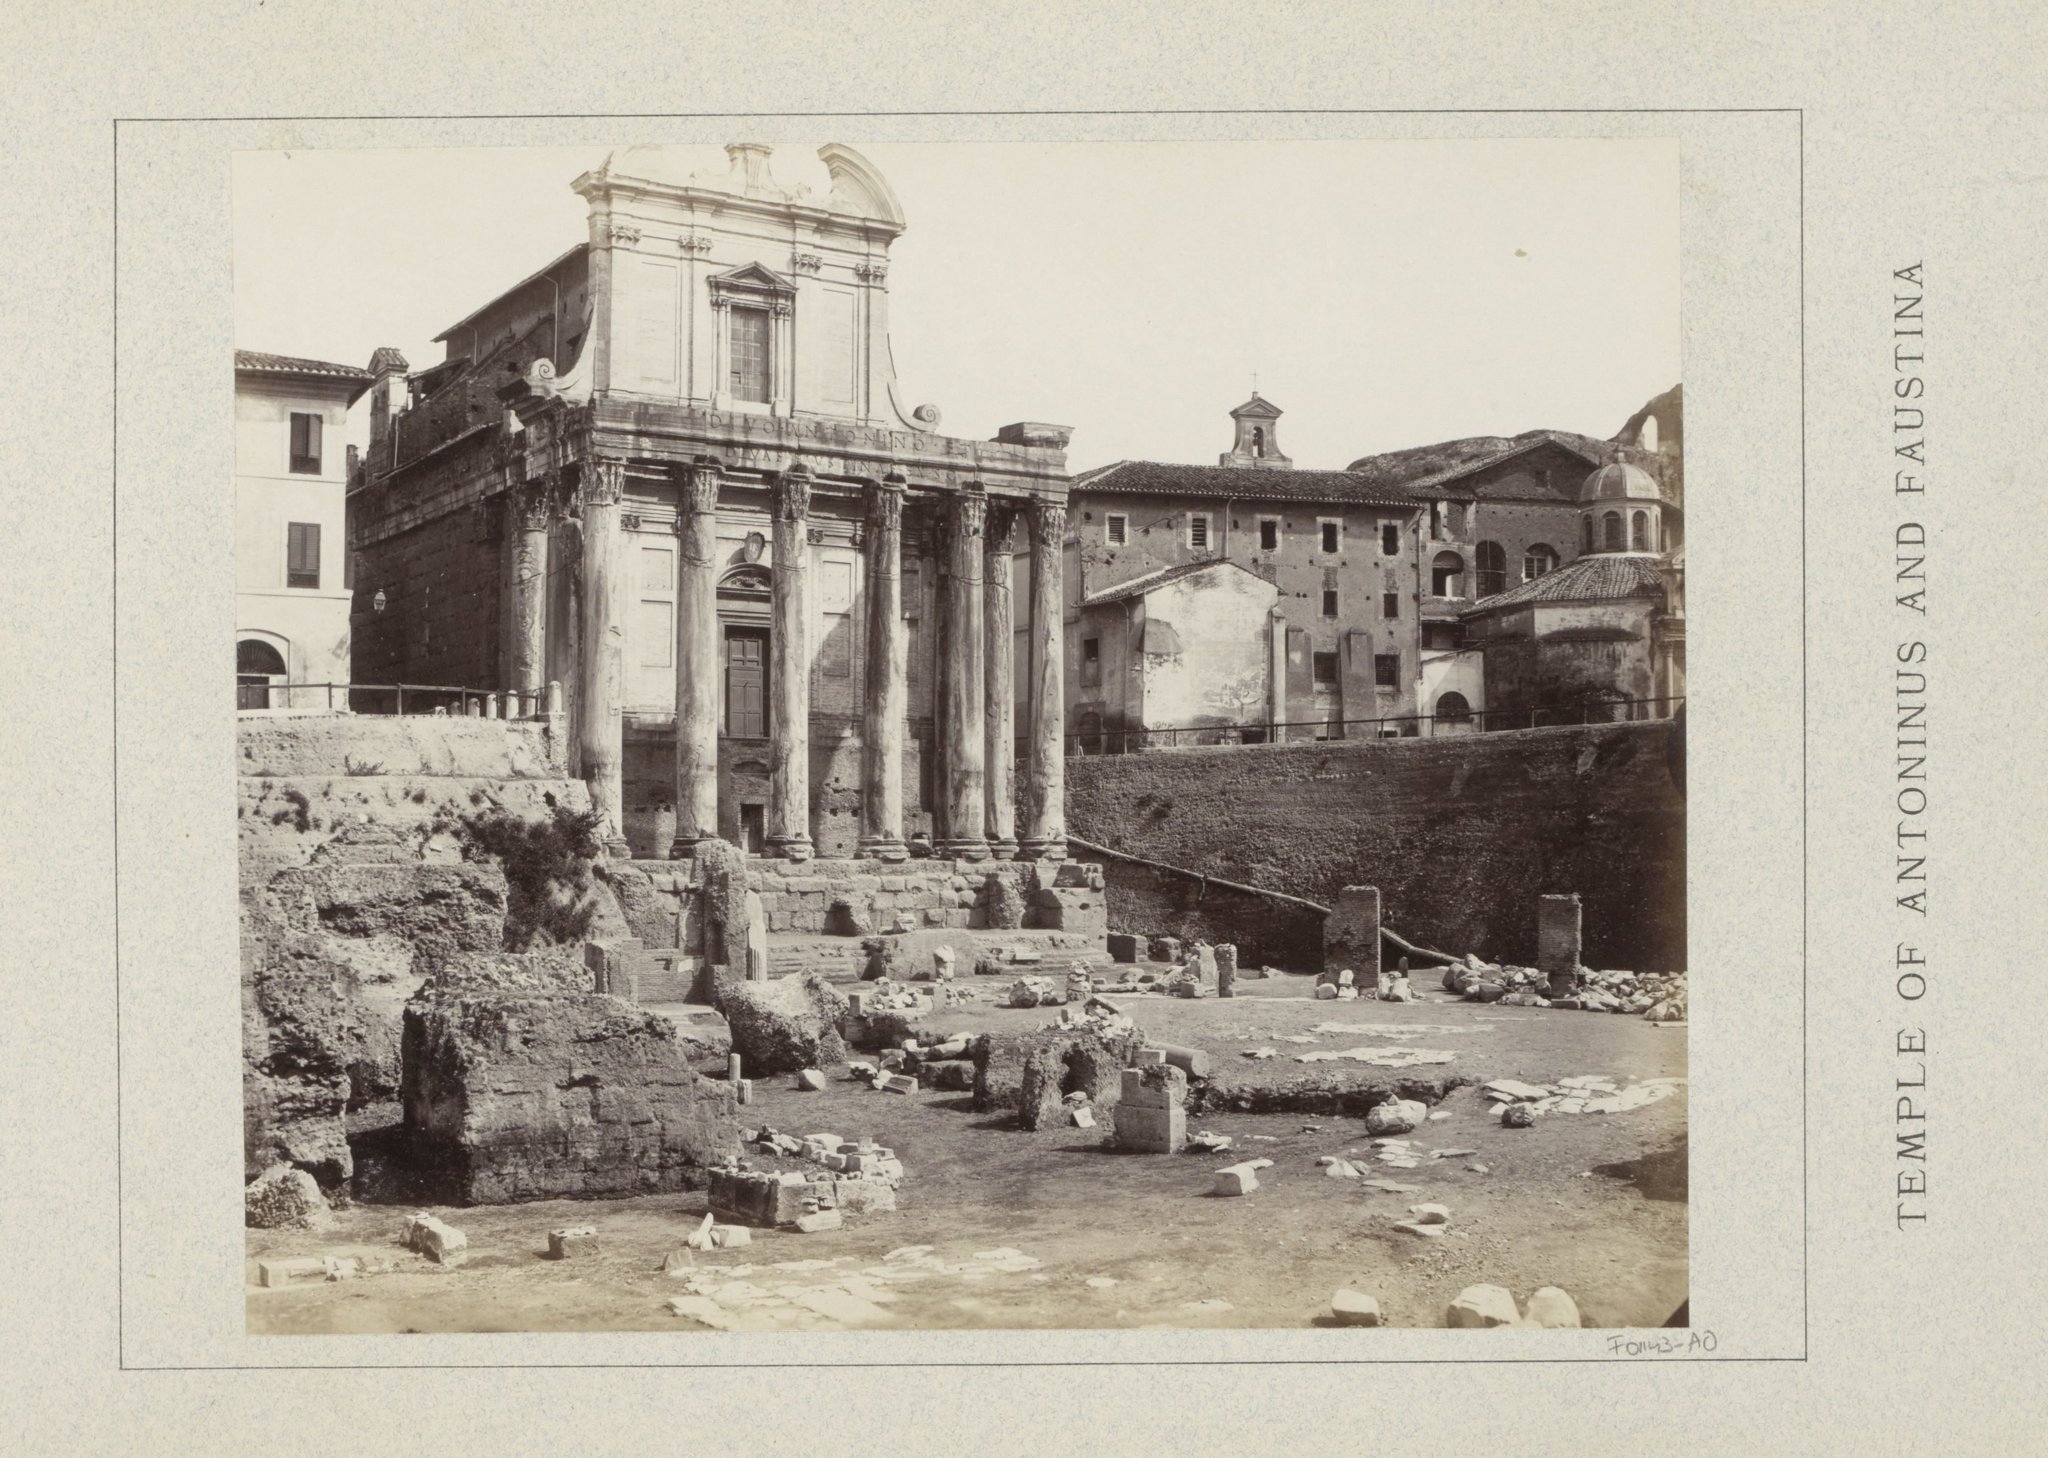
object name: photograph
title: Temple of Antoninus and Faustina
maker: Anonymous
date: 1860-1900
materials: photographic support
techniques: albumen print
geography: rome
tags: temple, shrine ~ roman religion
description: Onderdeel van Fotoalbum met opnames van bezienswaardigheden en kunstwerken in Rome.